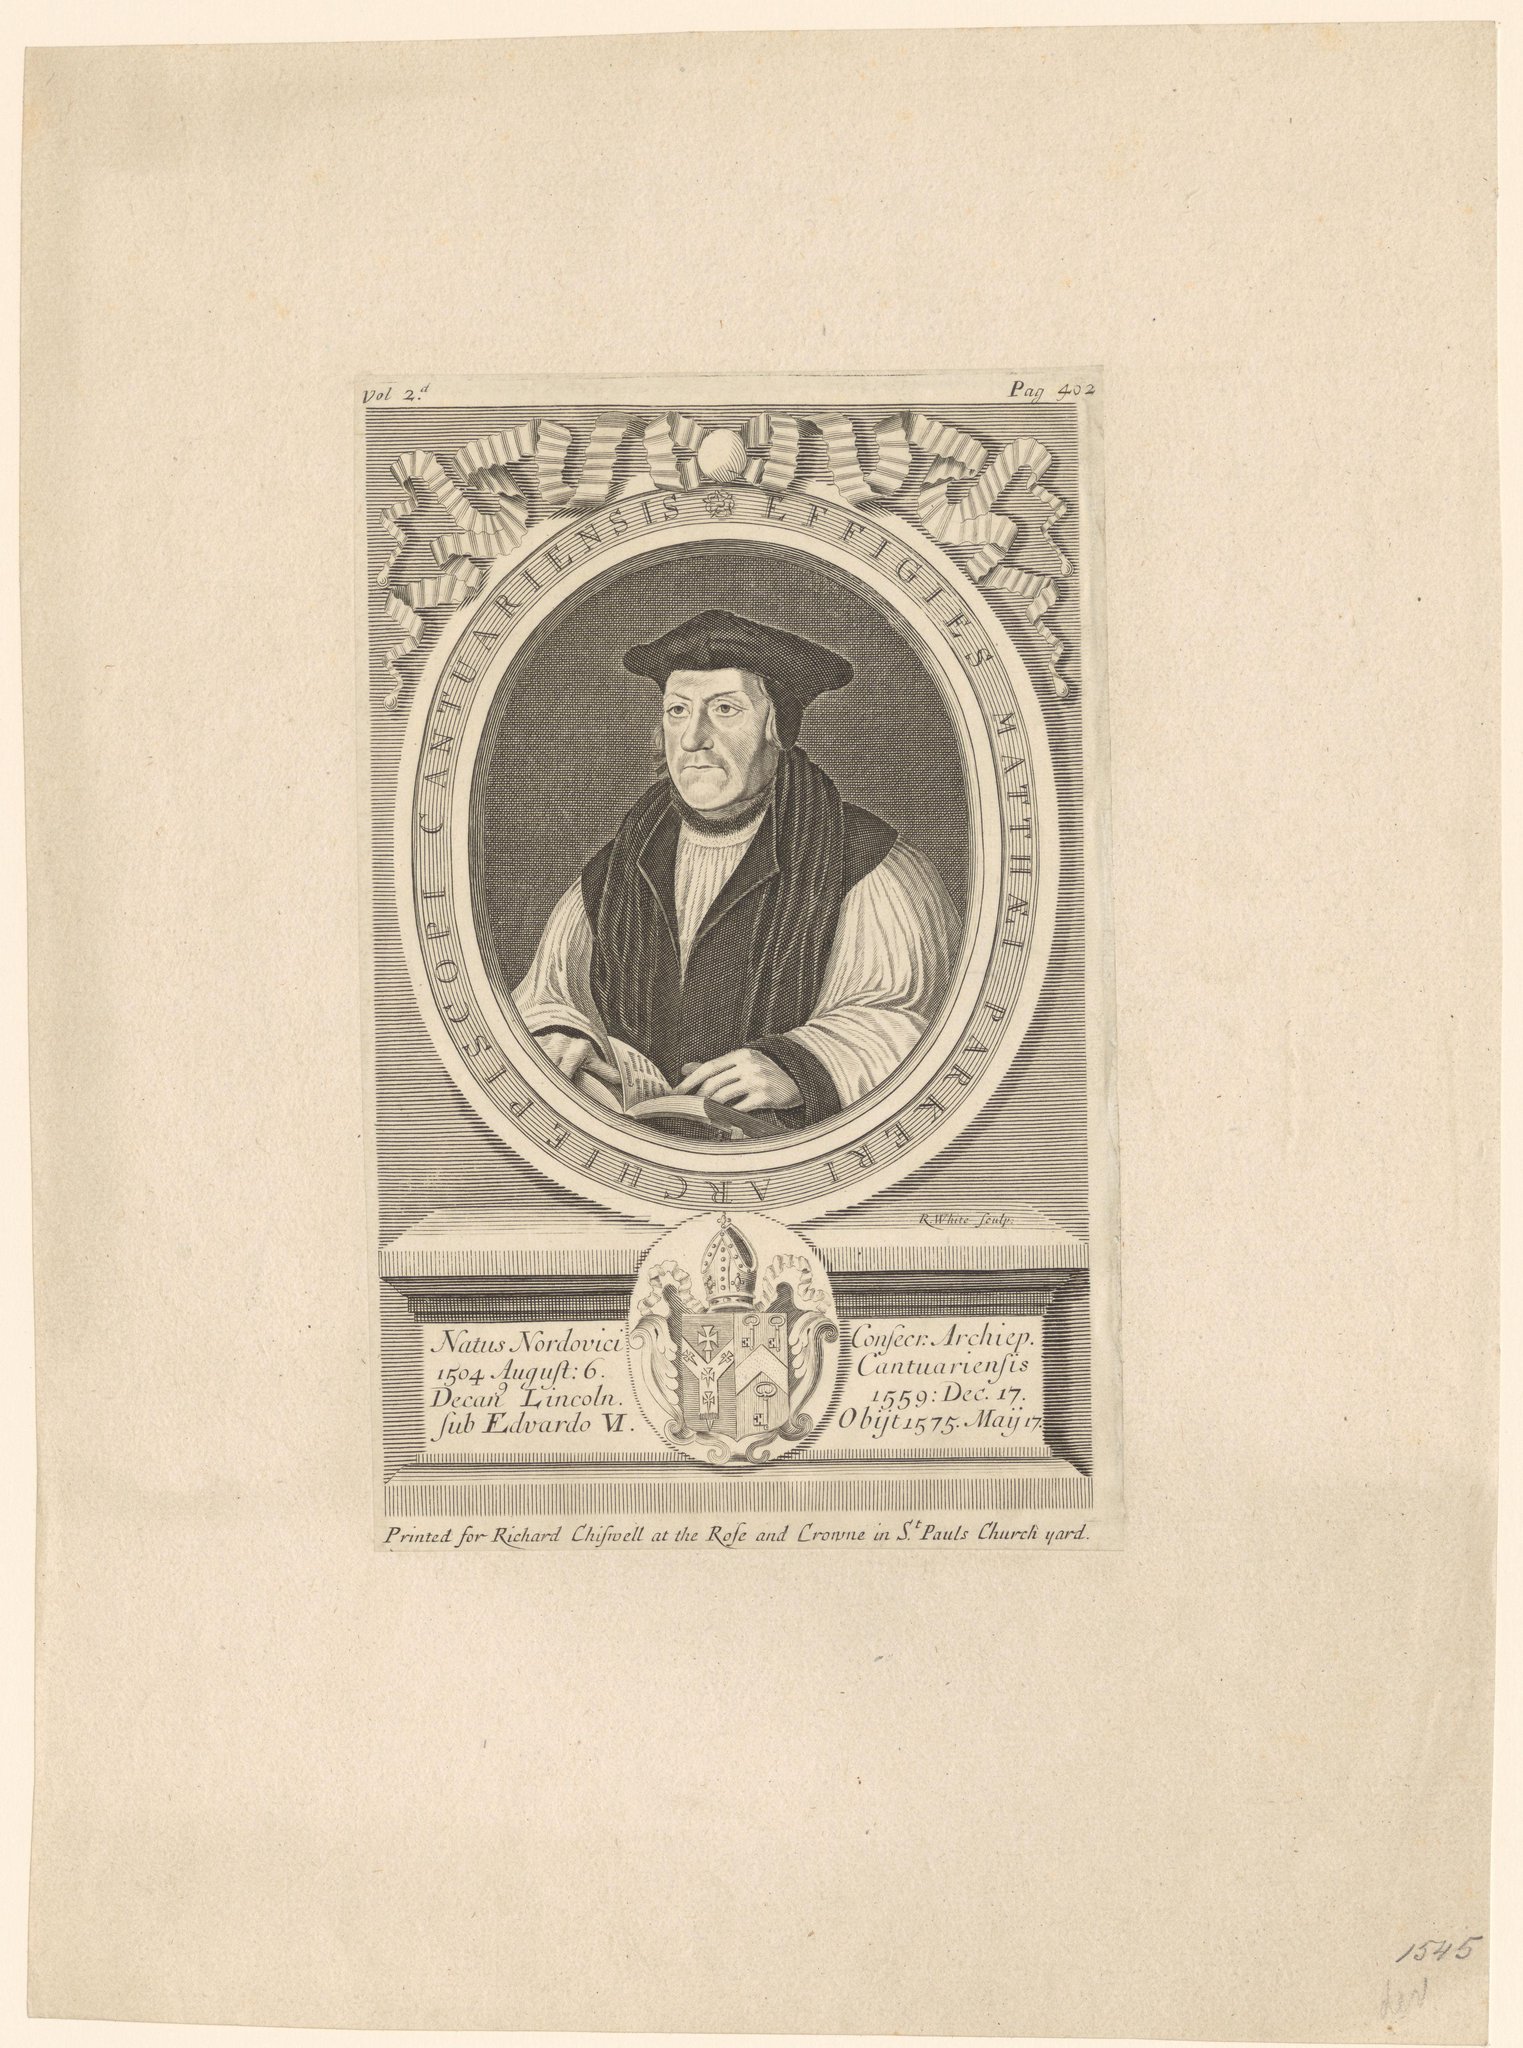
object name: book illustration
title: Portret van Matthew Parker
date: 1681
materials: paper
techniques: engraving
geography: london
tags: archbishop, bishop, etc. (roman catholic), historical persons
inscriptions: collector's mark: Lugt 2228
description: Prent uit: Burnet, Gilbert. The History of the Reformation of the Church of England. Londen: Richard Chiswell, 1681, dl. 2, p. 402.